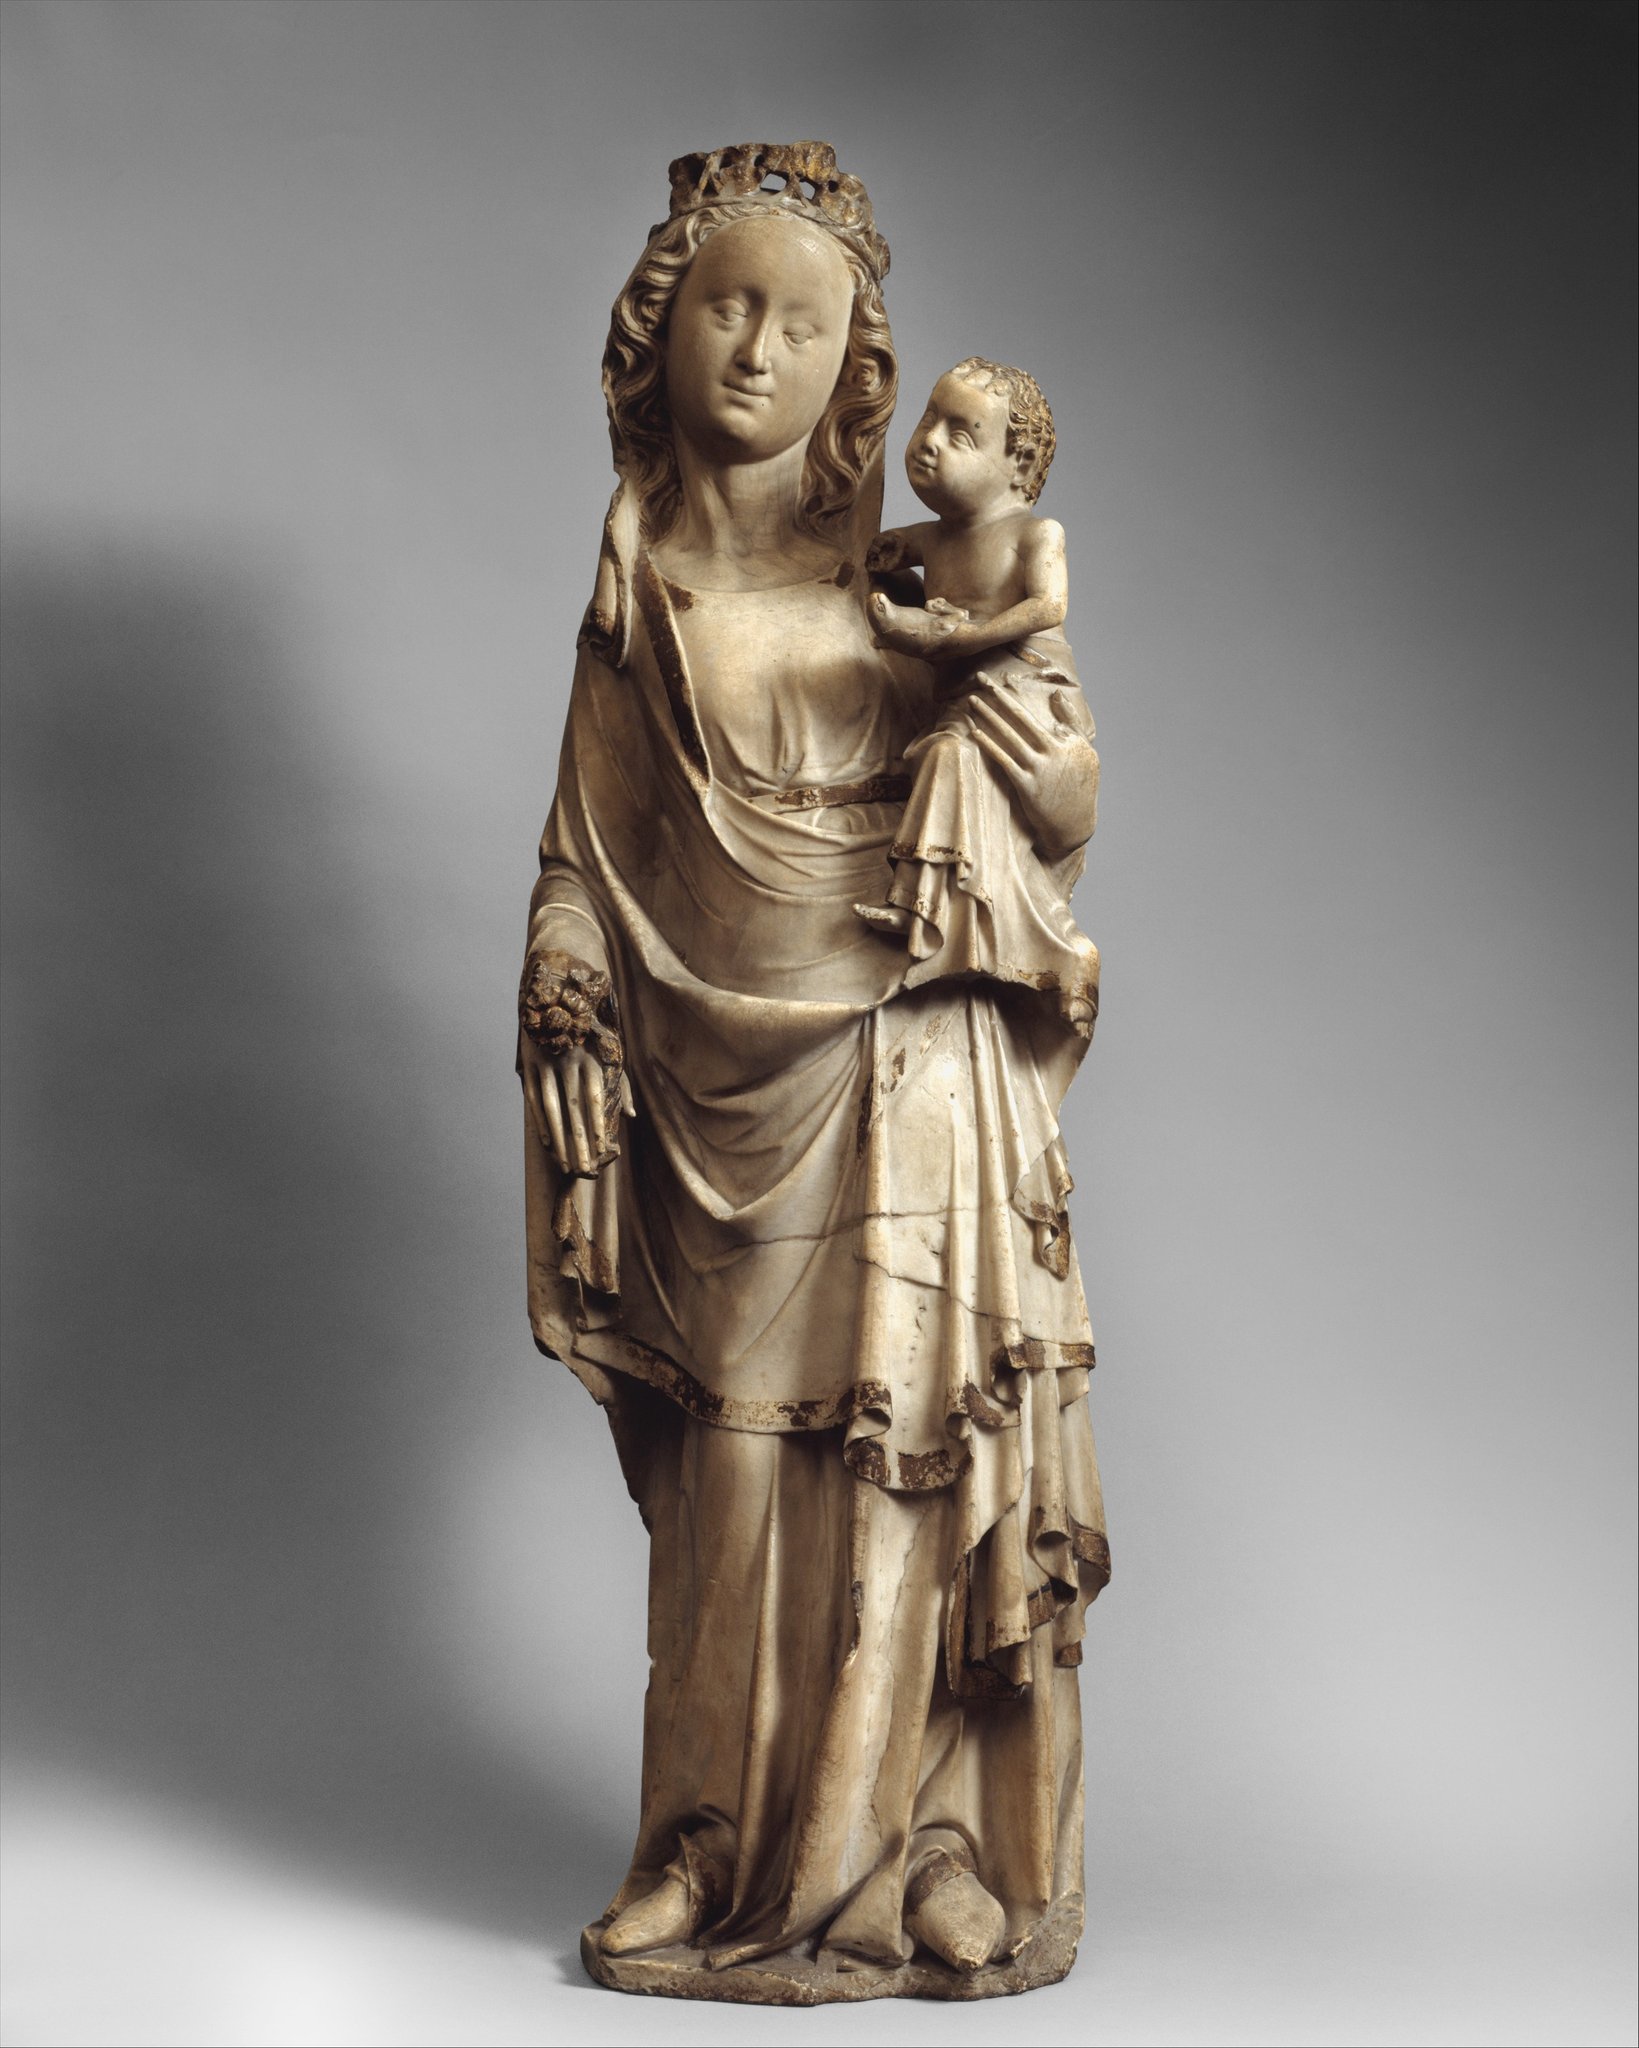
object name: statuette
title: Virgin and Child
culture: french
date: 1350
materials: marble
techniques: gilding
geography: france